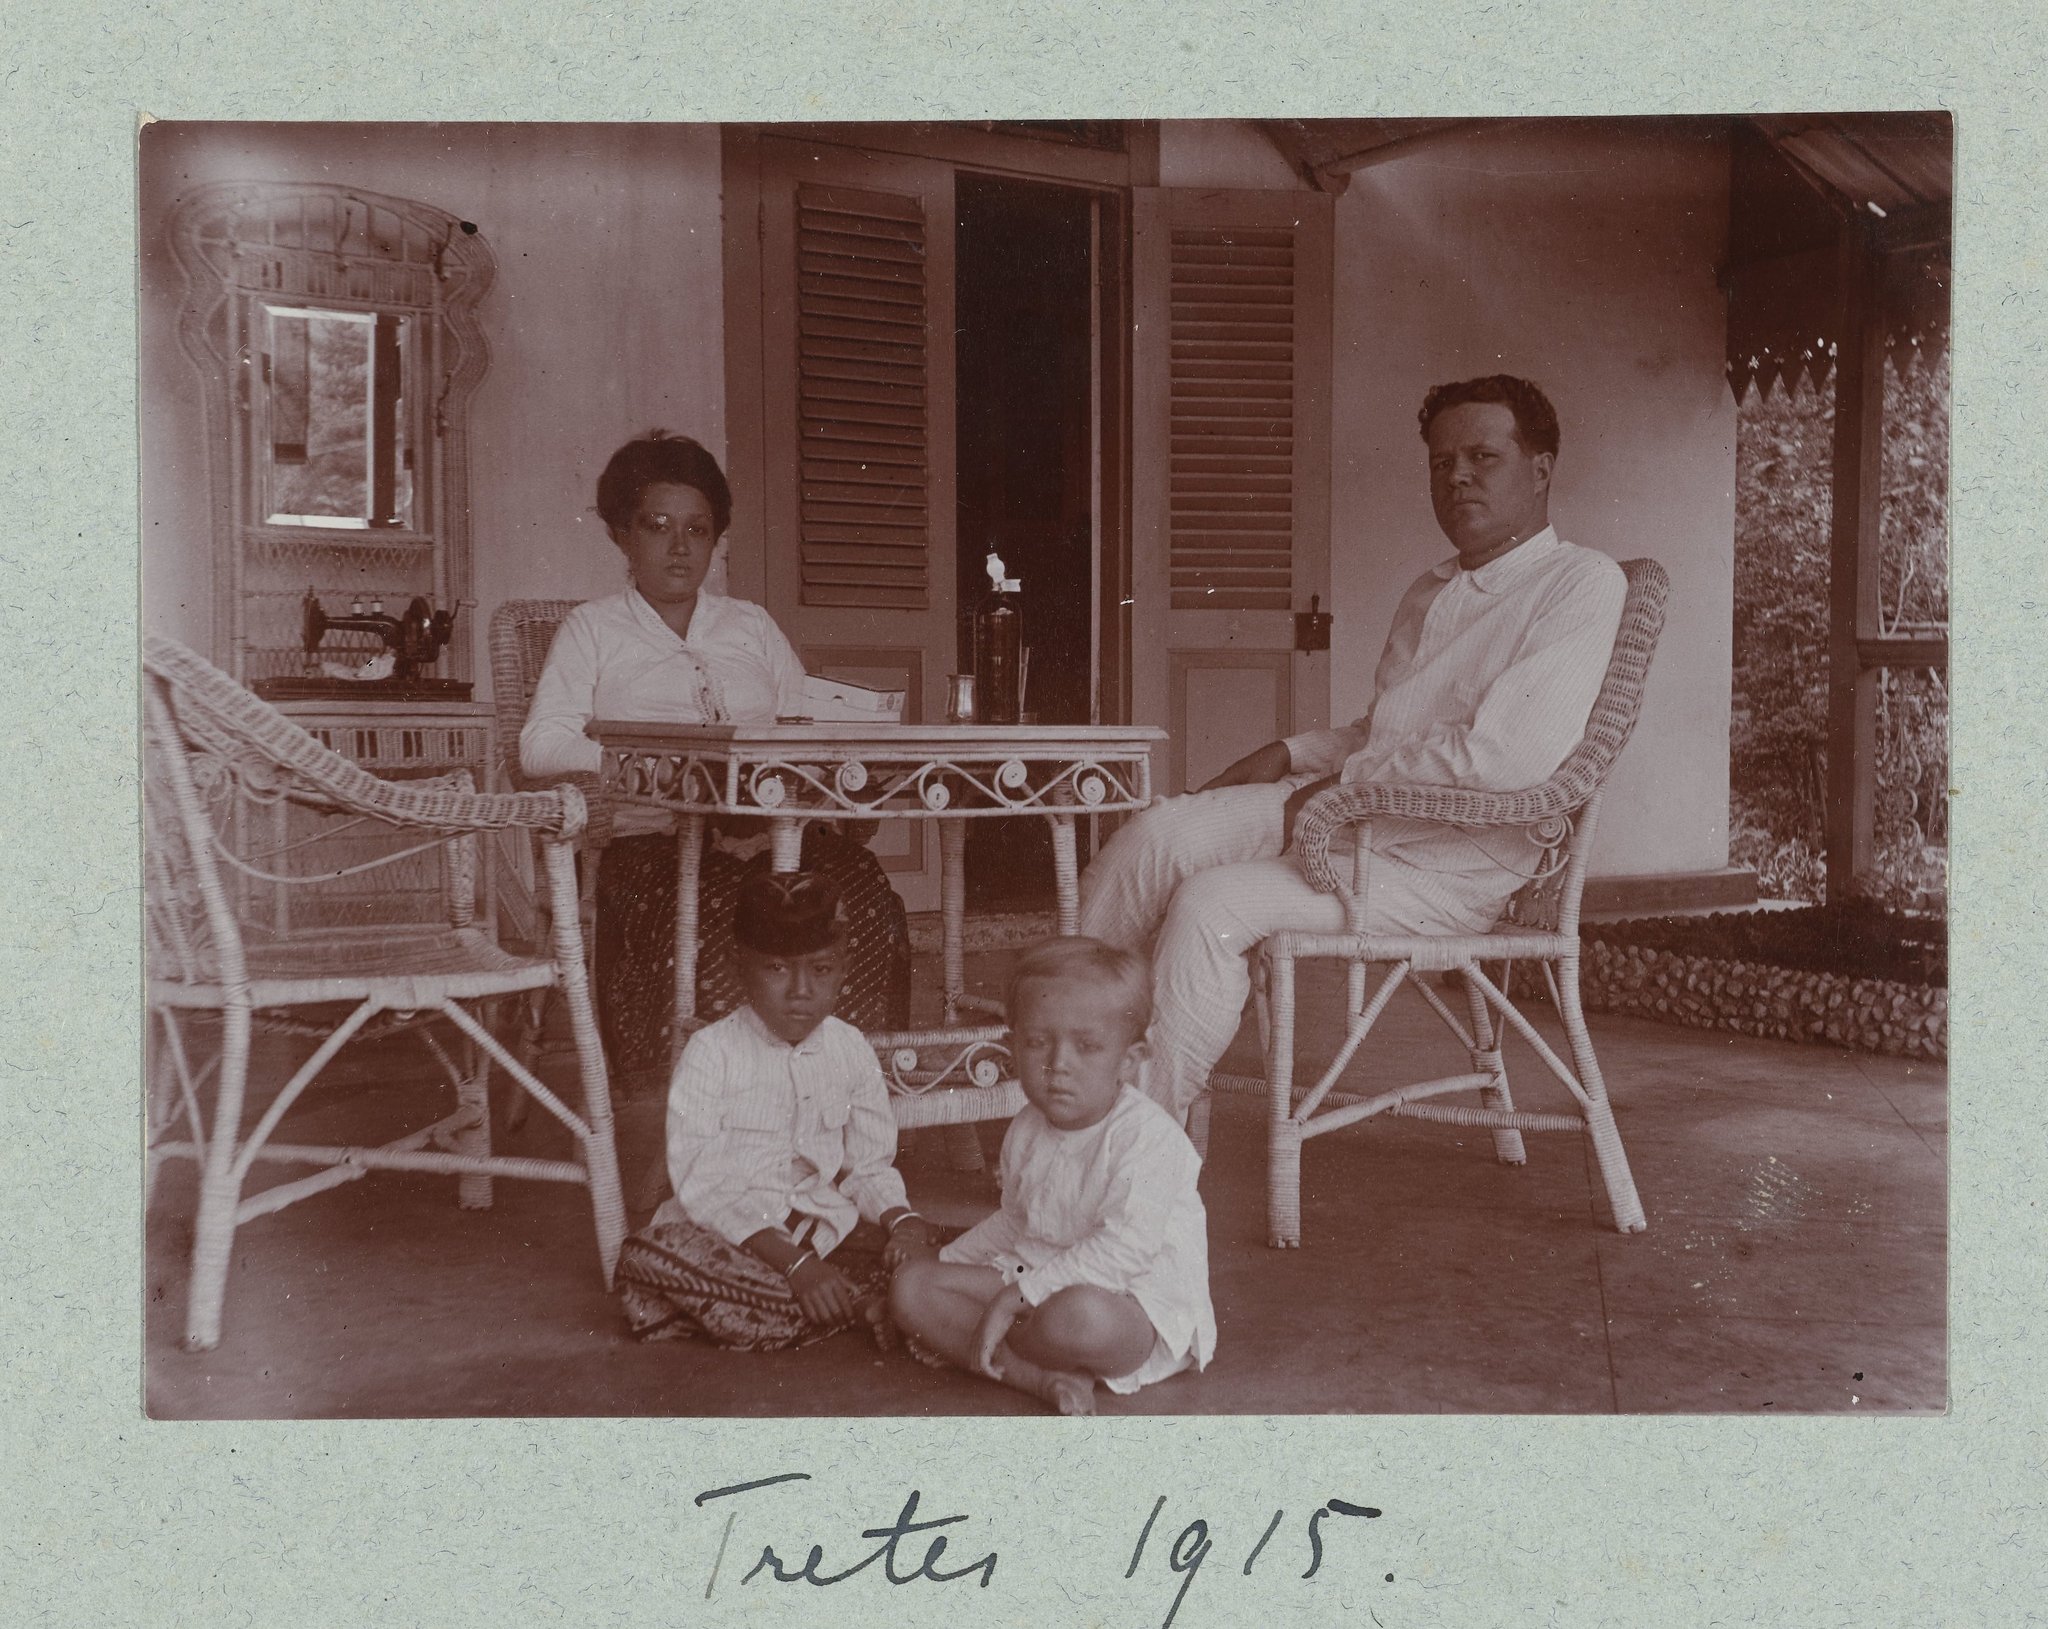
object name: photograph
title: Tretes 1915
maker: frits freerks fontein fz.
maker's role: fotograaf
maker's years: 1882-1928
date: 1914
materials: cardboard, paper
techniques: gelatin silver print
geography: madura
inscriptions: caption: ‘Tretes 1915’